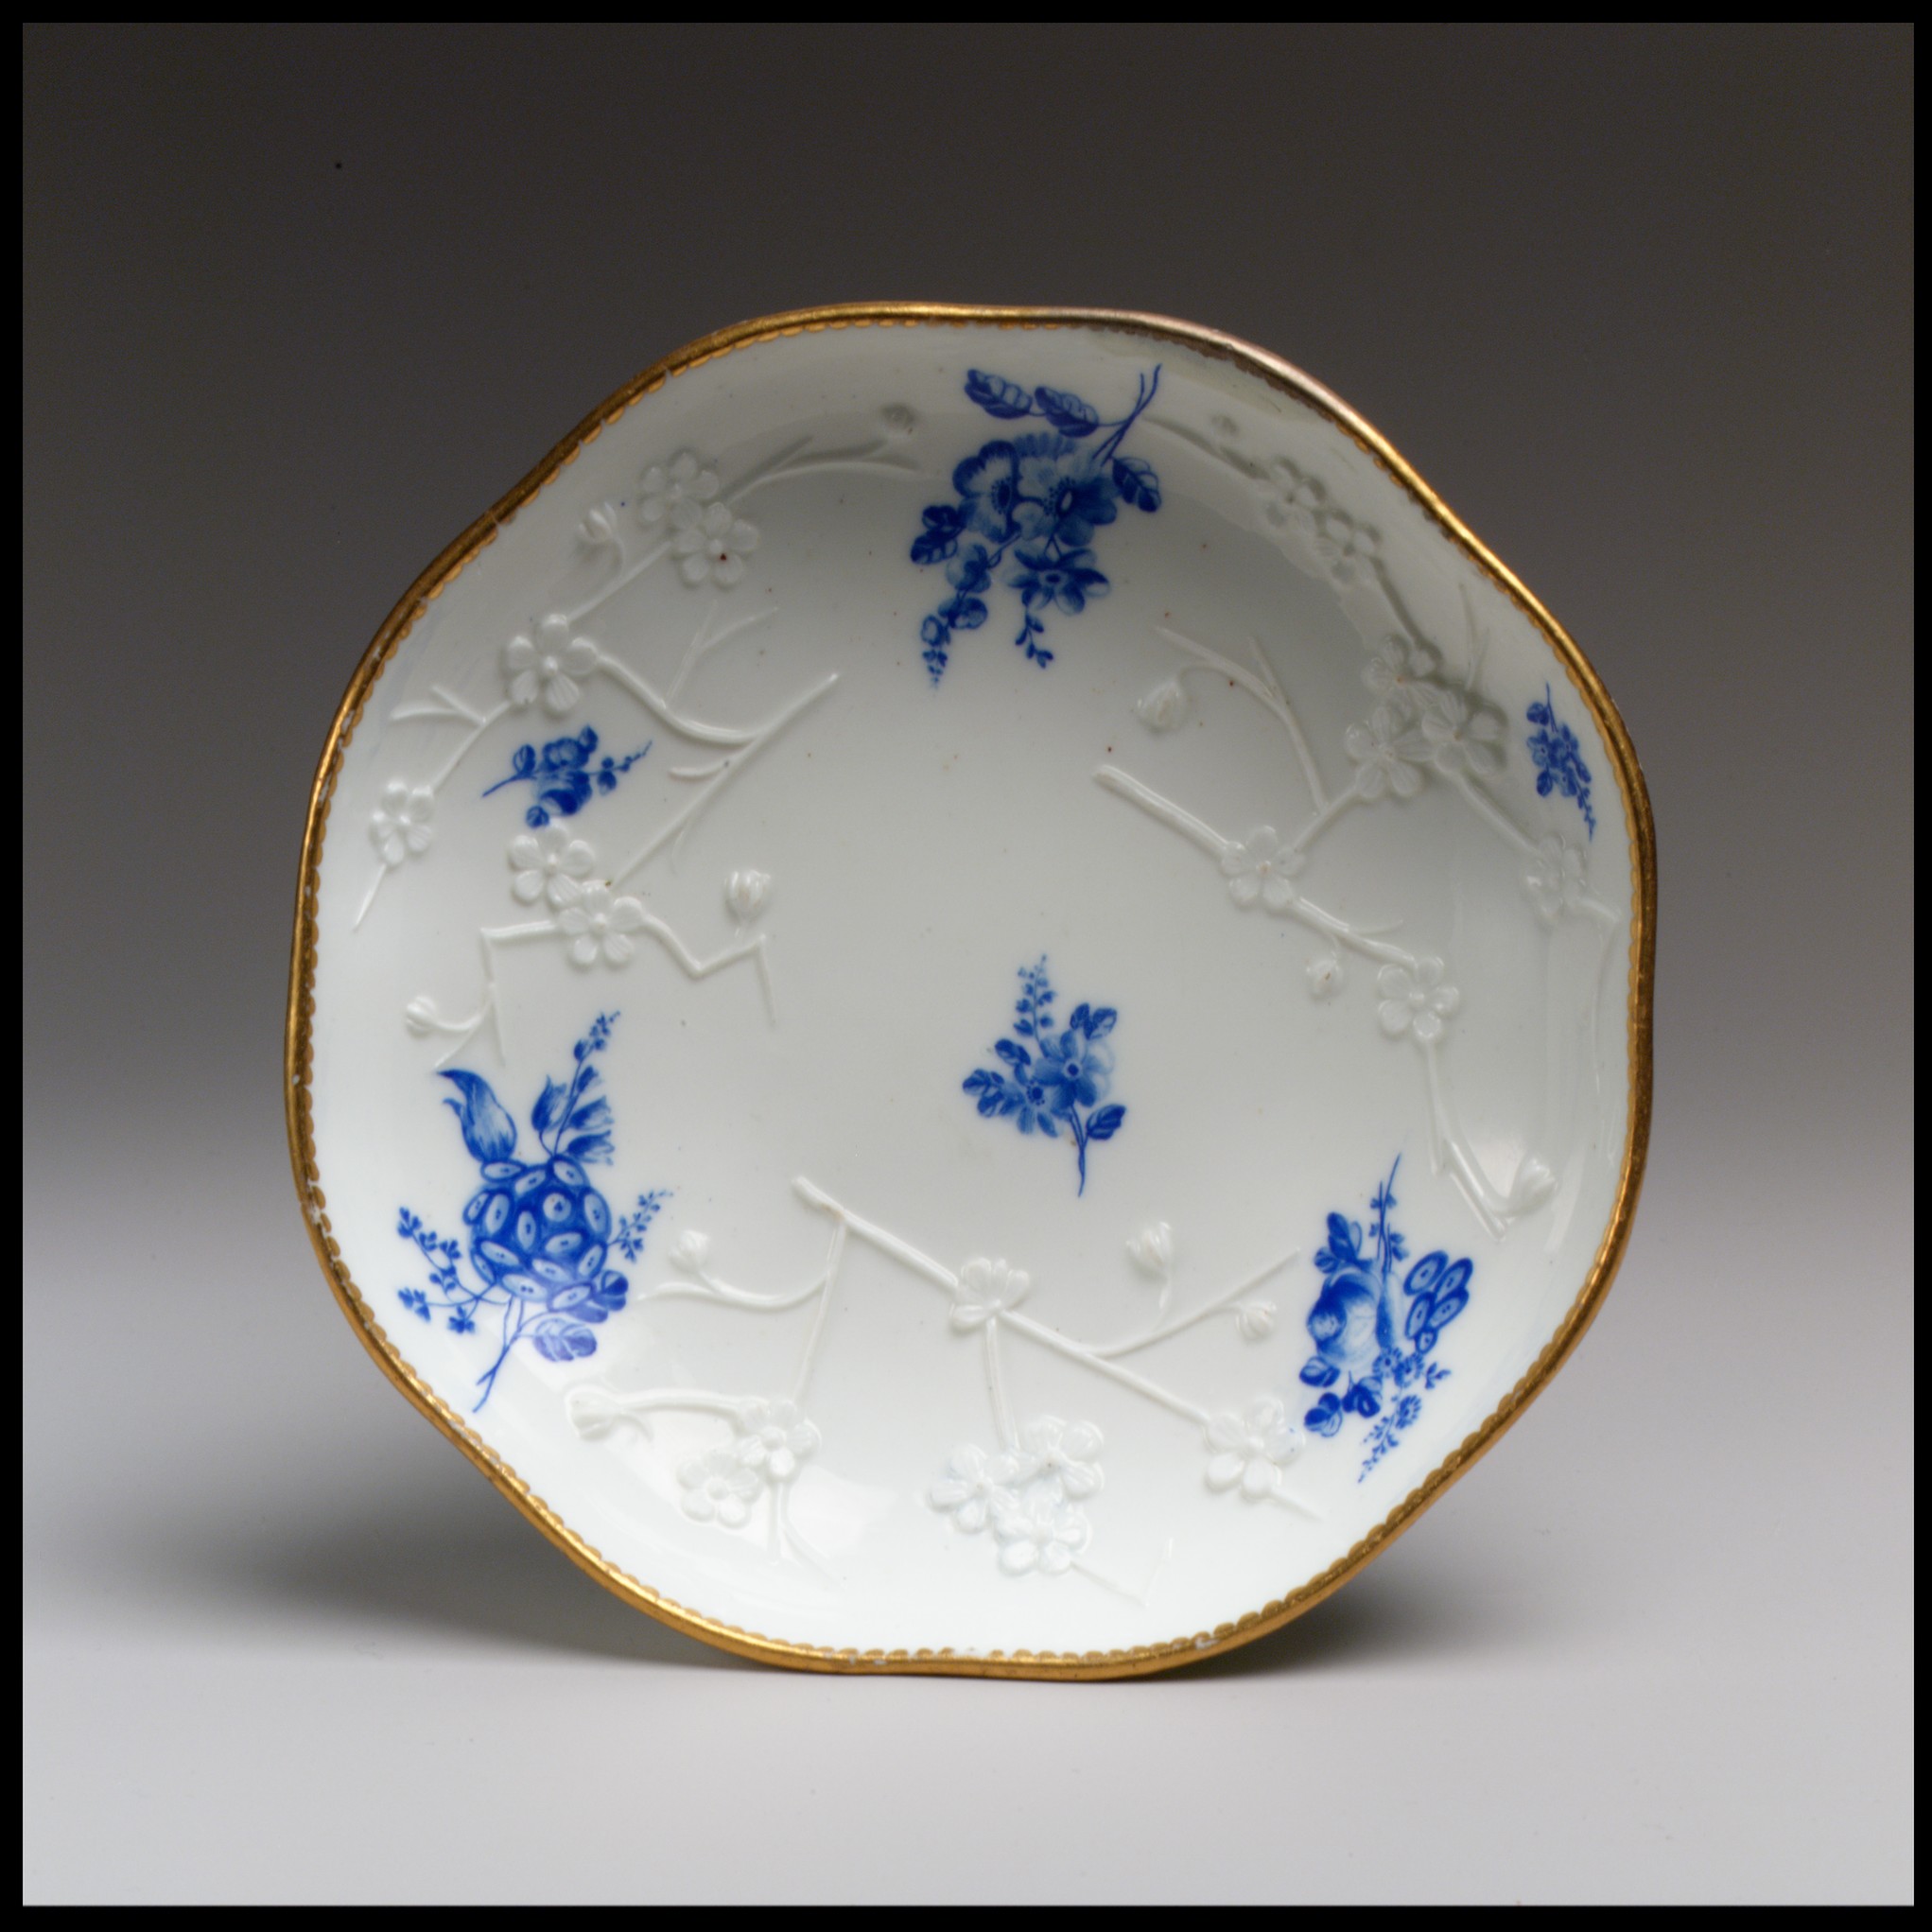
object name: saucer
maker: vincennes manufactory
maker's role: manufactory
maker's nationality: french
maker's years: 1740-1756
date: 1759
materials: soft paste porcelain